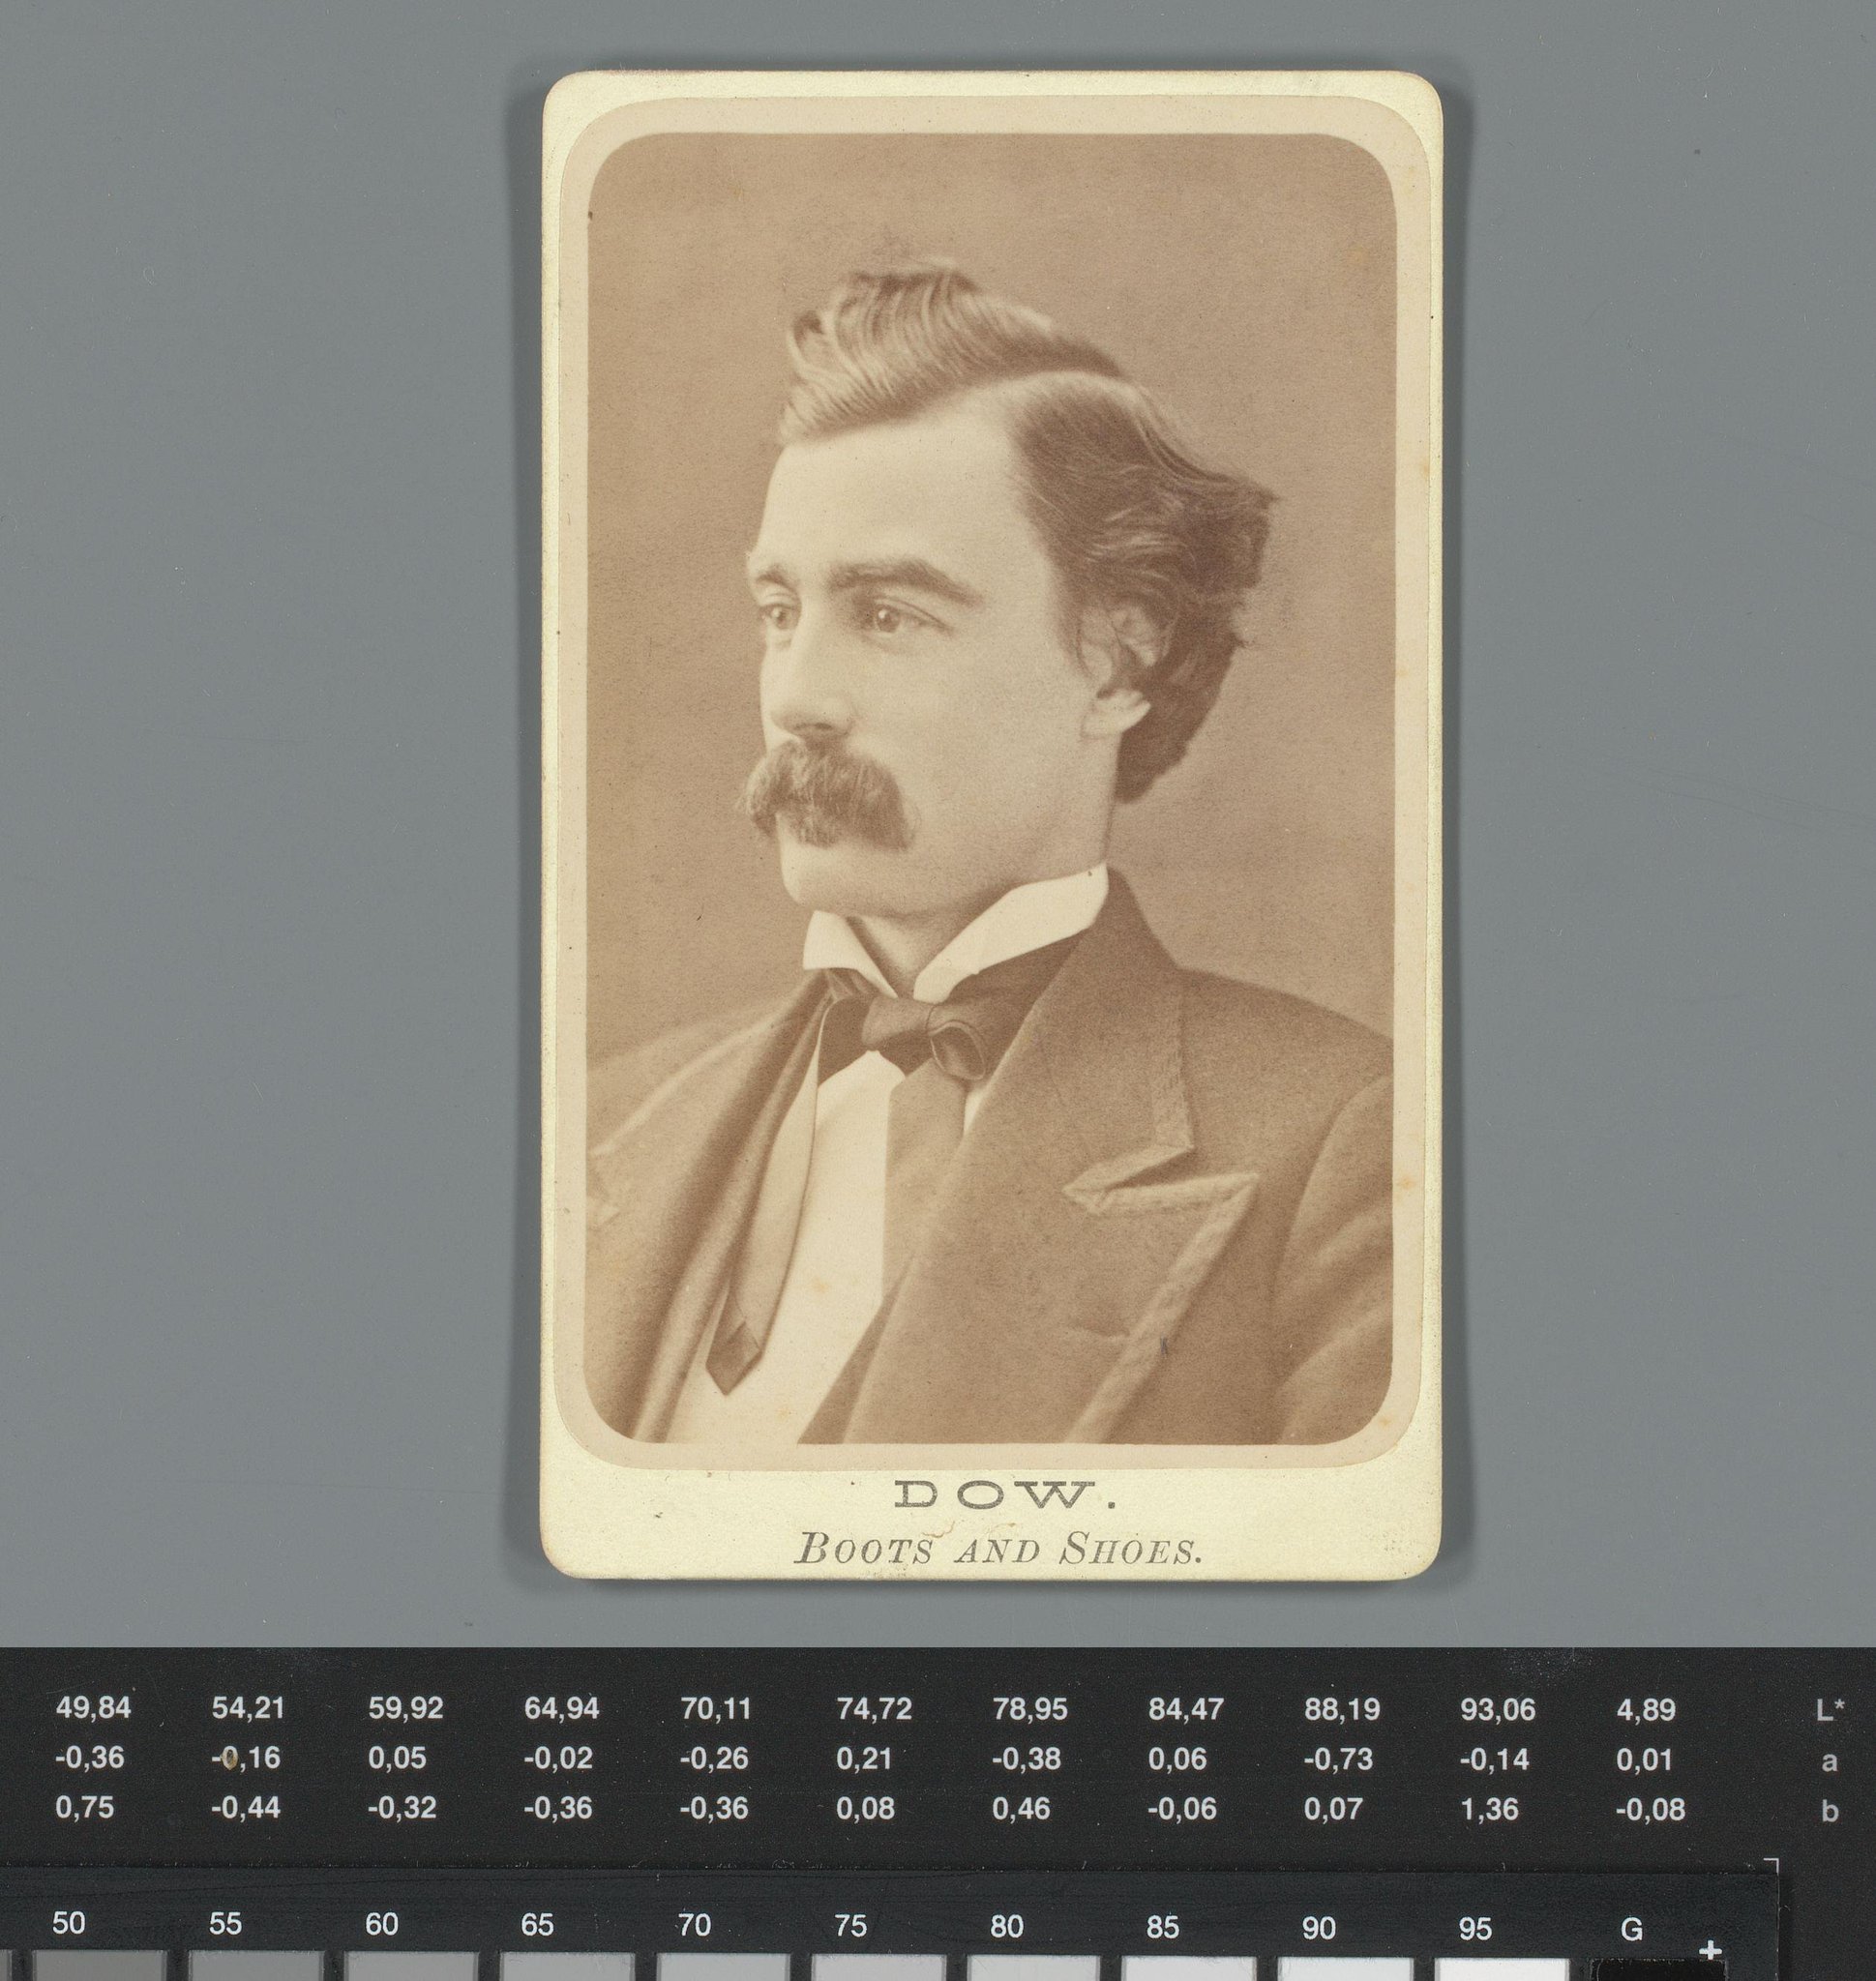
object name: photograph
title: Reclame voor Dow schoenen met portret van een onbekende man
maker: s. piper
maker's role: fotograaf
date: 1850-1915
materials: cardboard, photographic support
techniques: albumen print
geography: manchester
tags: advertising, historical persons not known by name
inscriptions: inscription: ‘From the/ Studio/ of/ S. Piper/ No. 905 Elm St./ Manchester, N.H.’